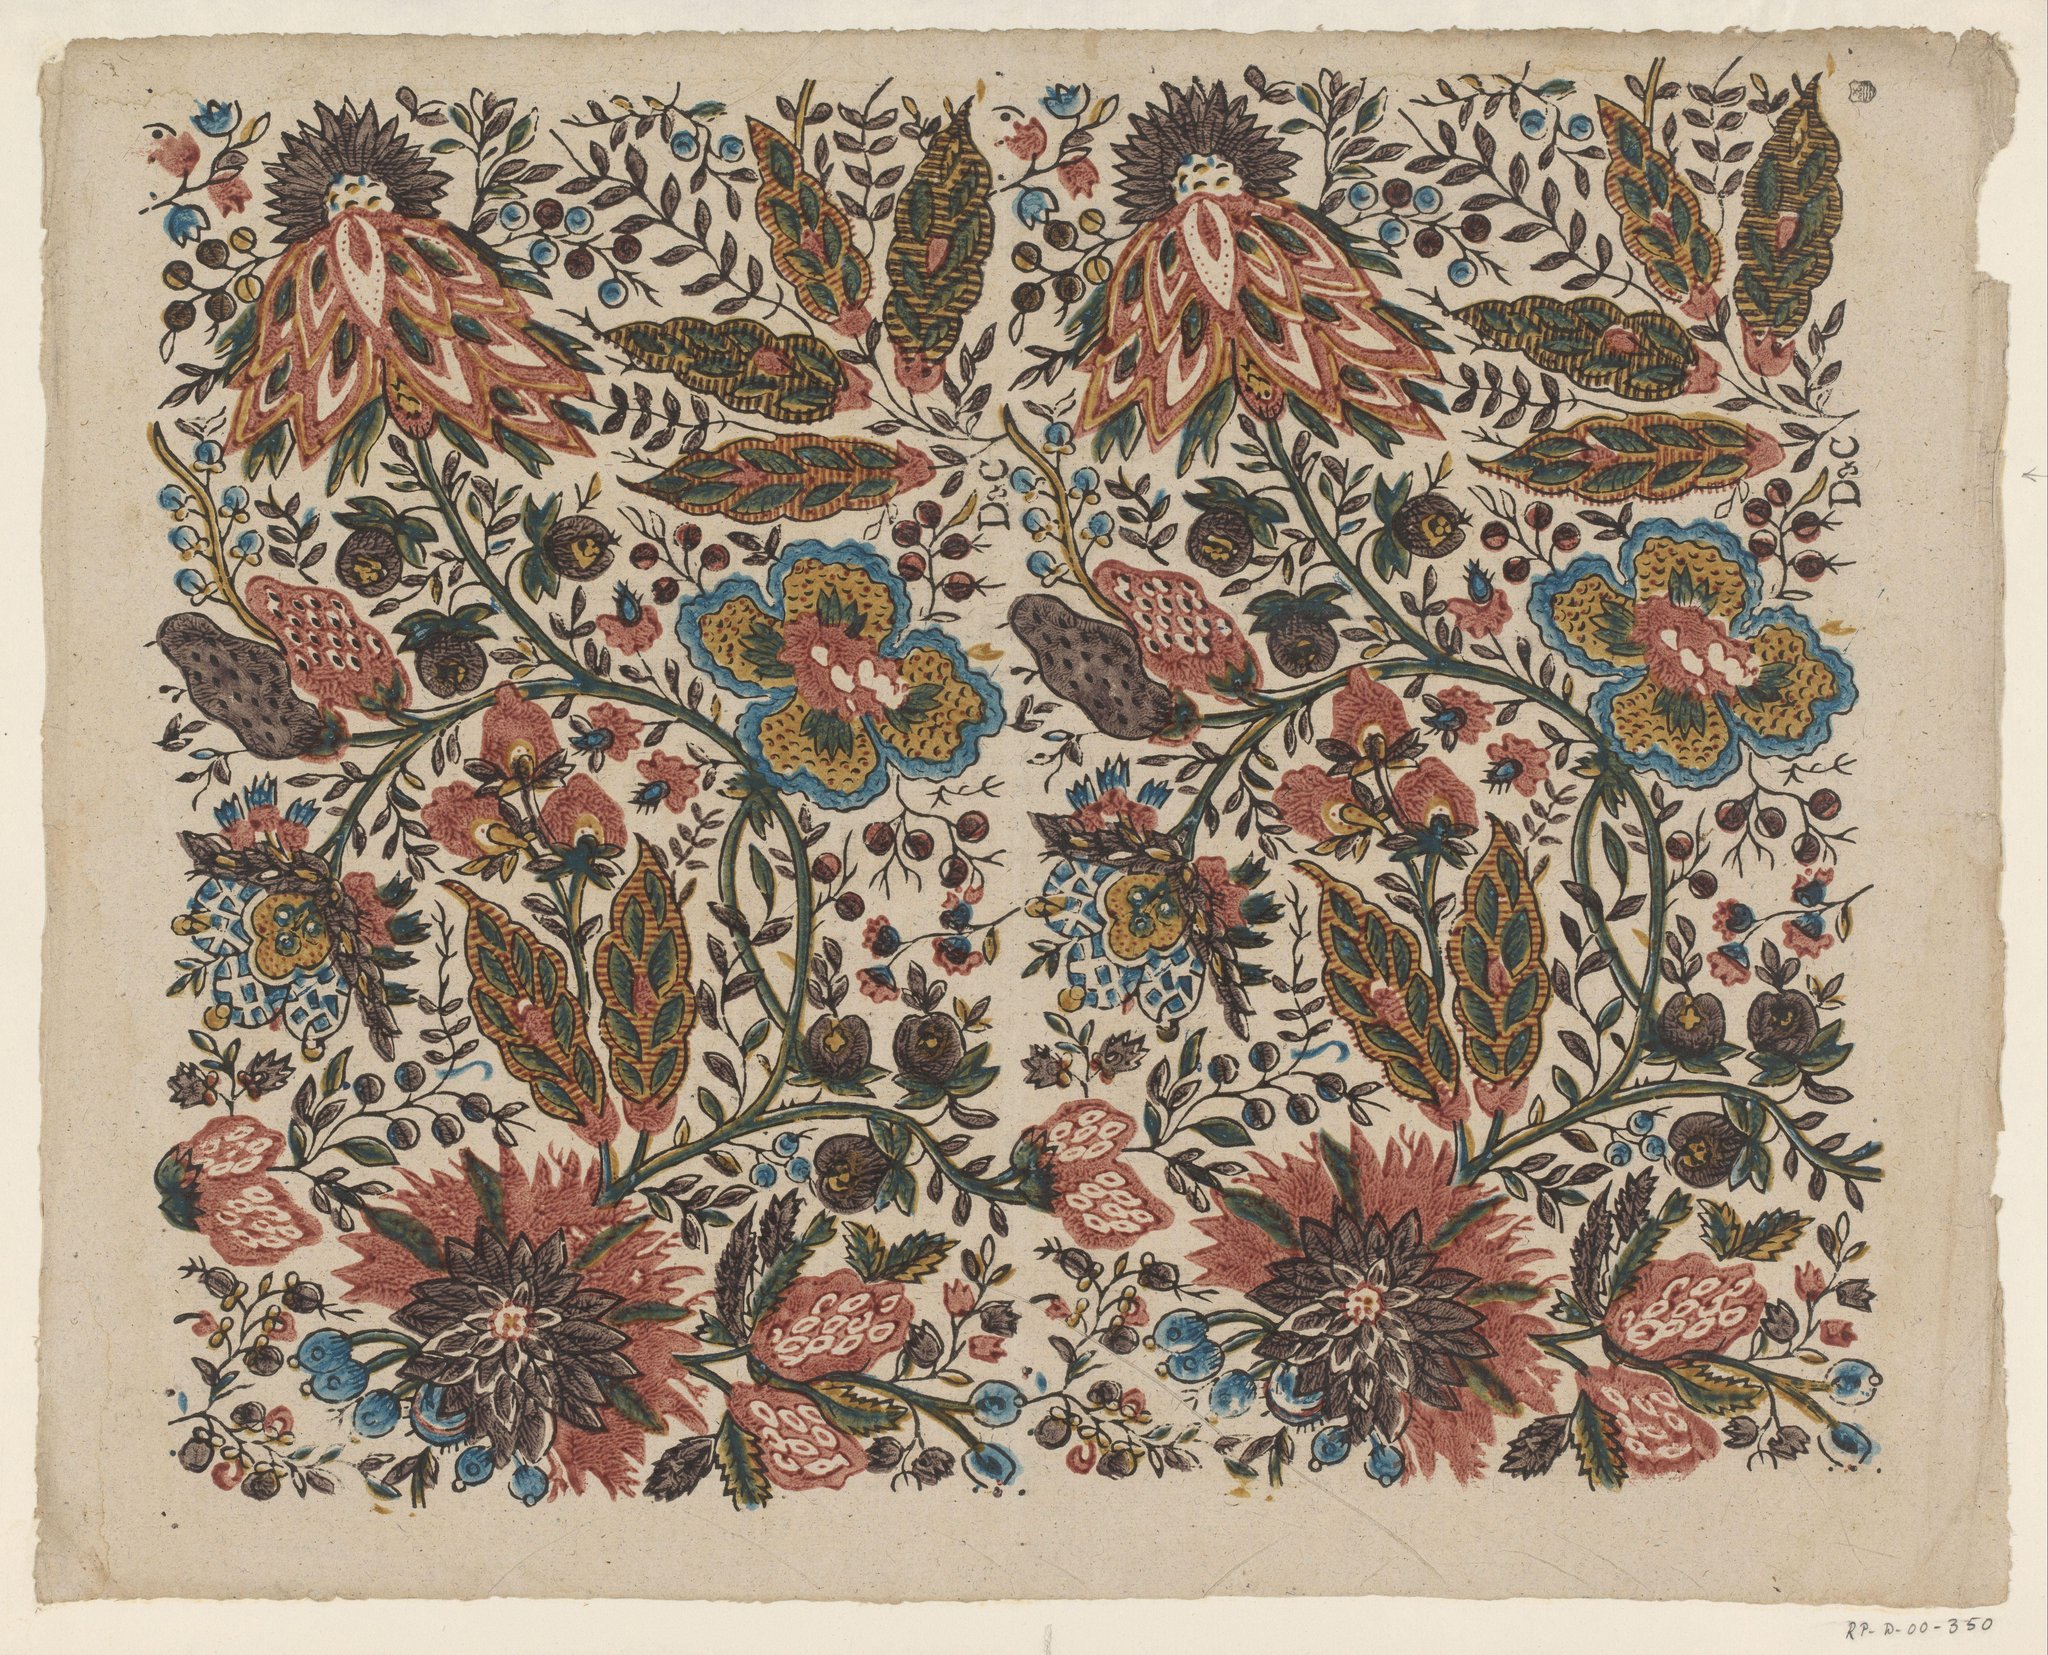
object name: printed paper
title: Blad met fantasie 'Perzische' bloemen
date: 1800-1850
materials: paper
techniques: printing block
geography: netherlands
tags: ornament derived from plant forms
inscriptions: collector's mark: Lugt 2760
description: Blad met fantasie 'Perzische' bloemen. Links en rechts identieke helften.